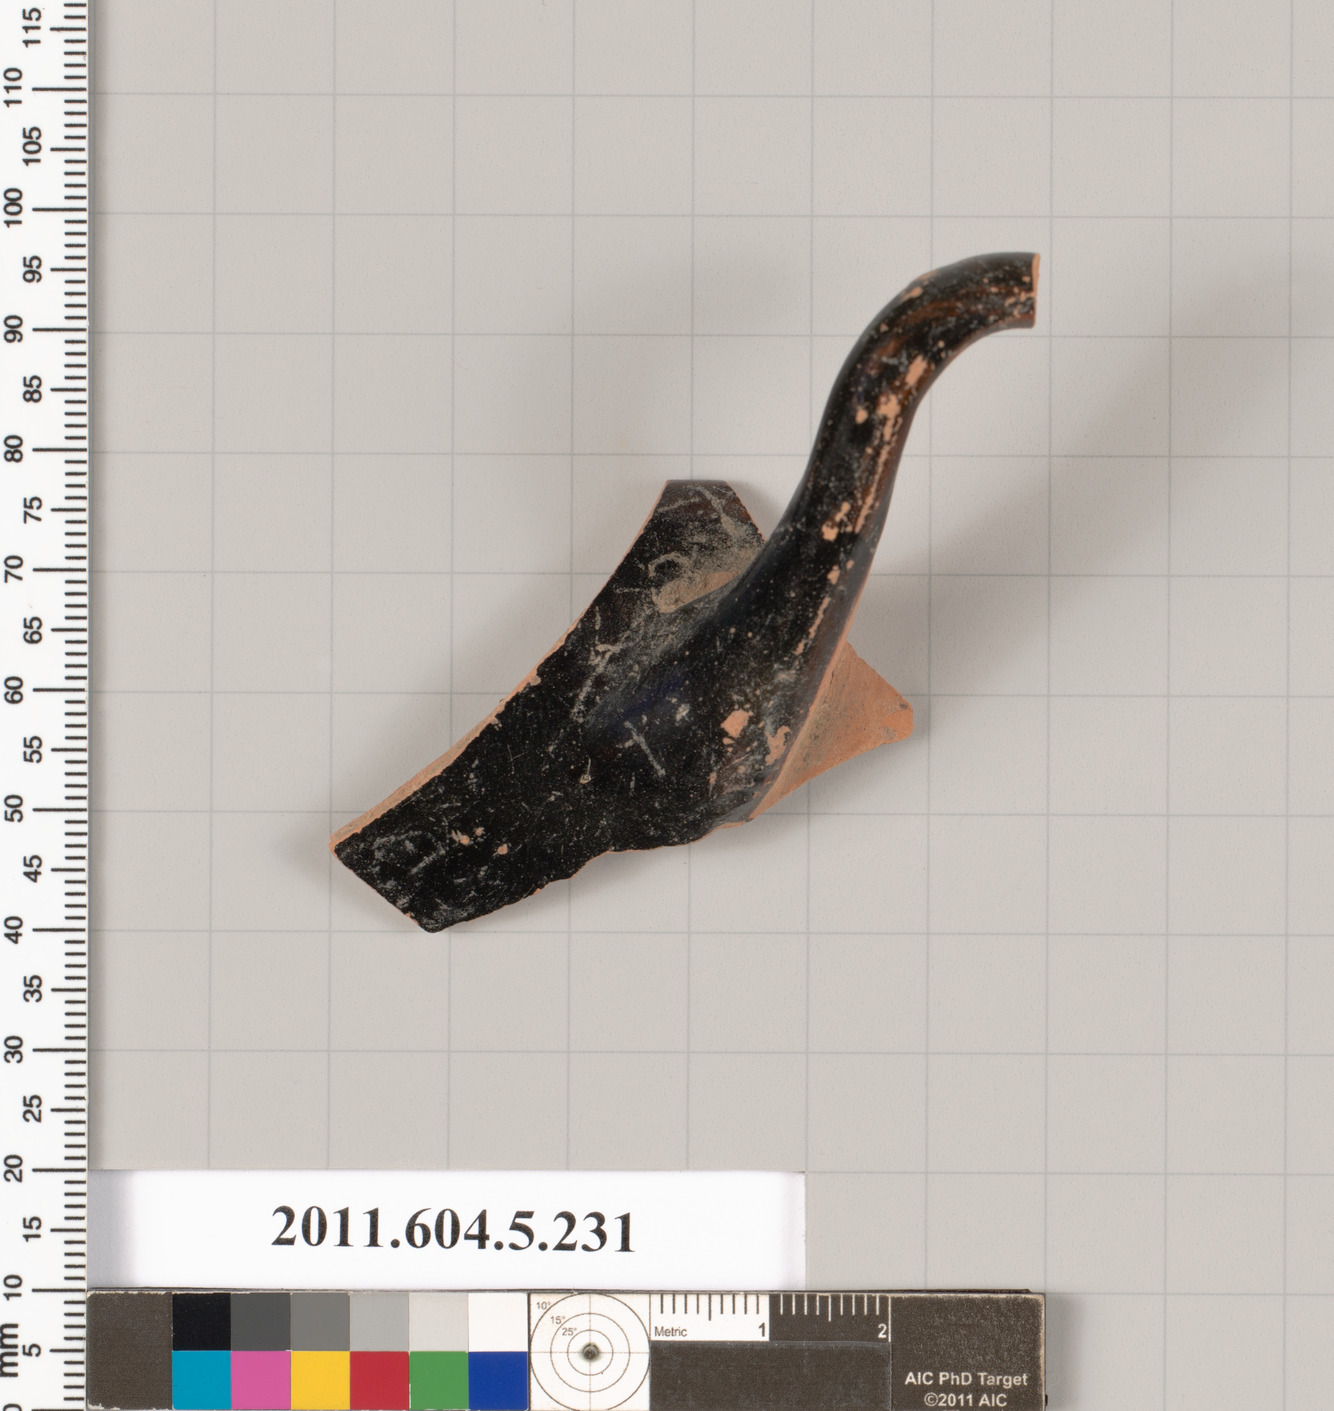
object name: kylix fragment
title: Terracotta rim fragment of a kylix (drinking cup)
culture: greek, attic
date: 600-401 BCE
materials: terracotta